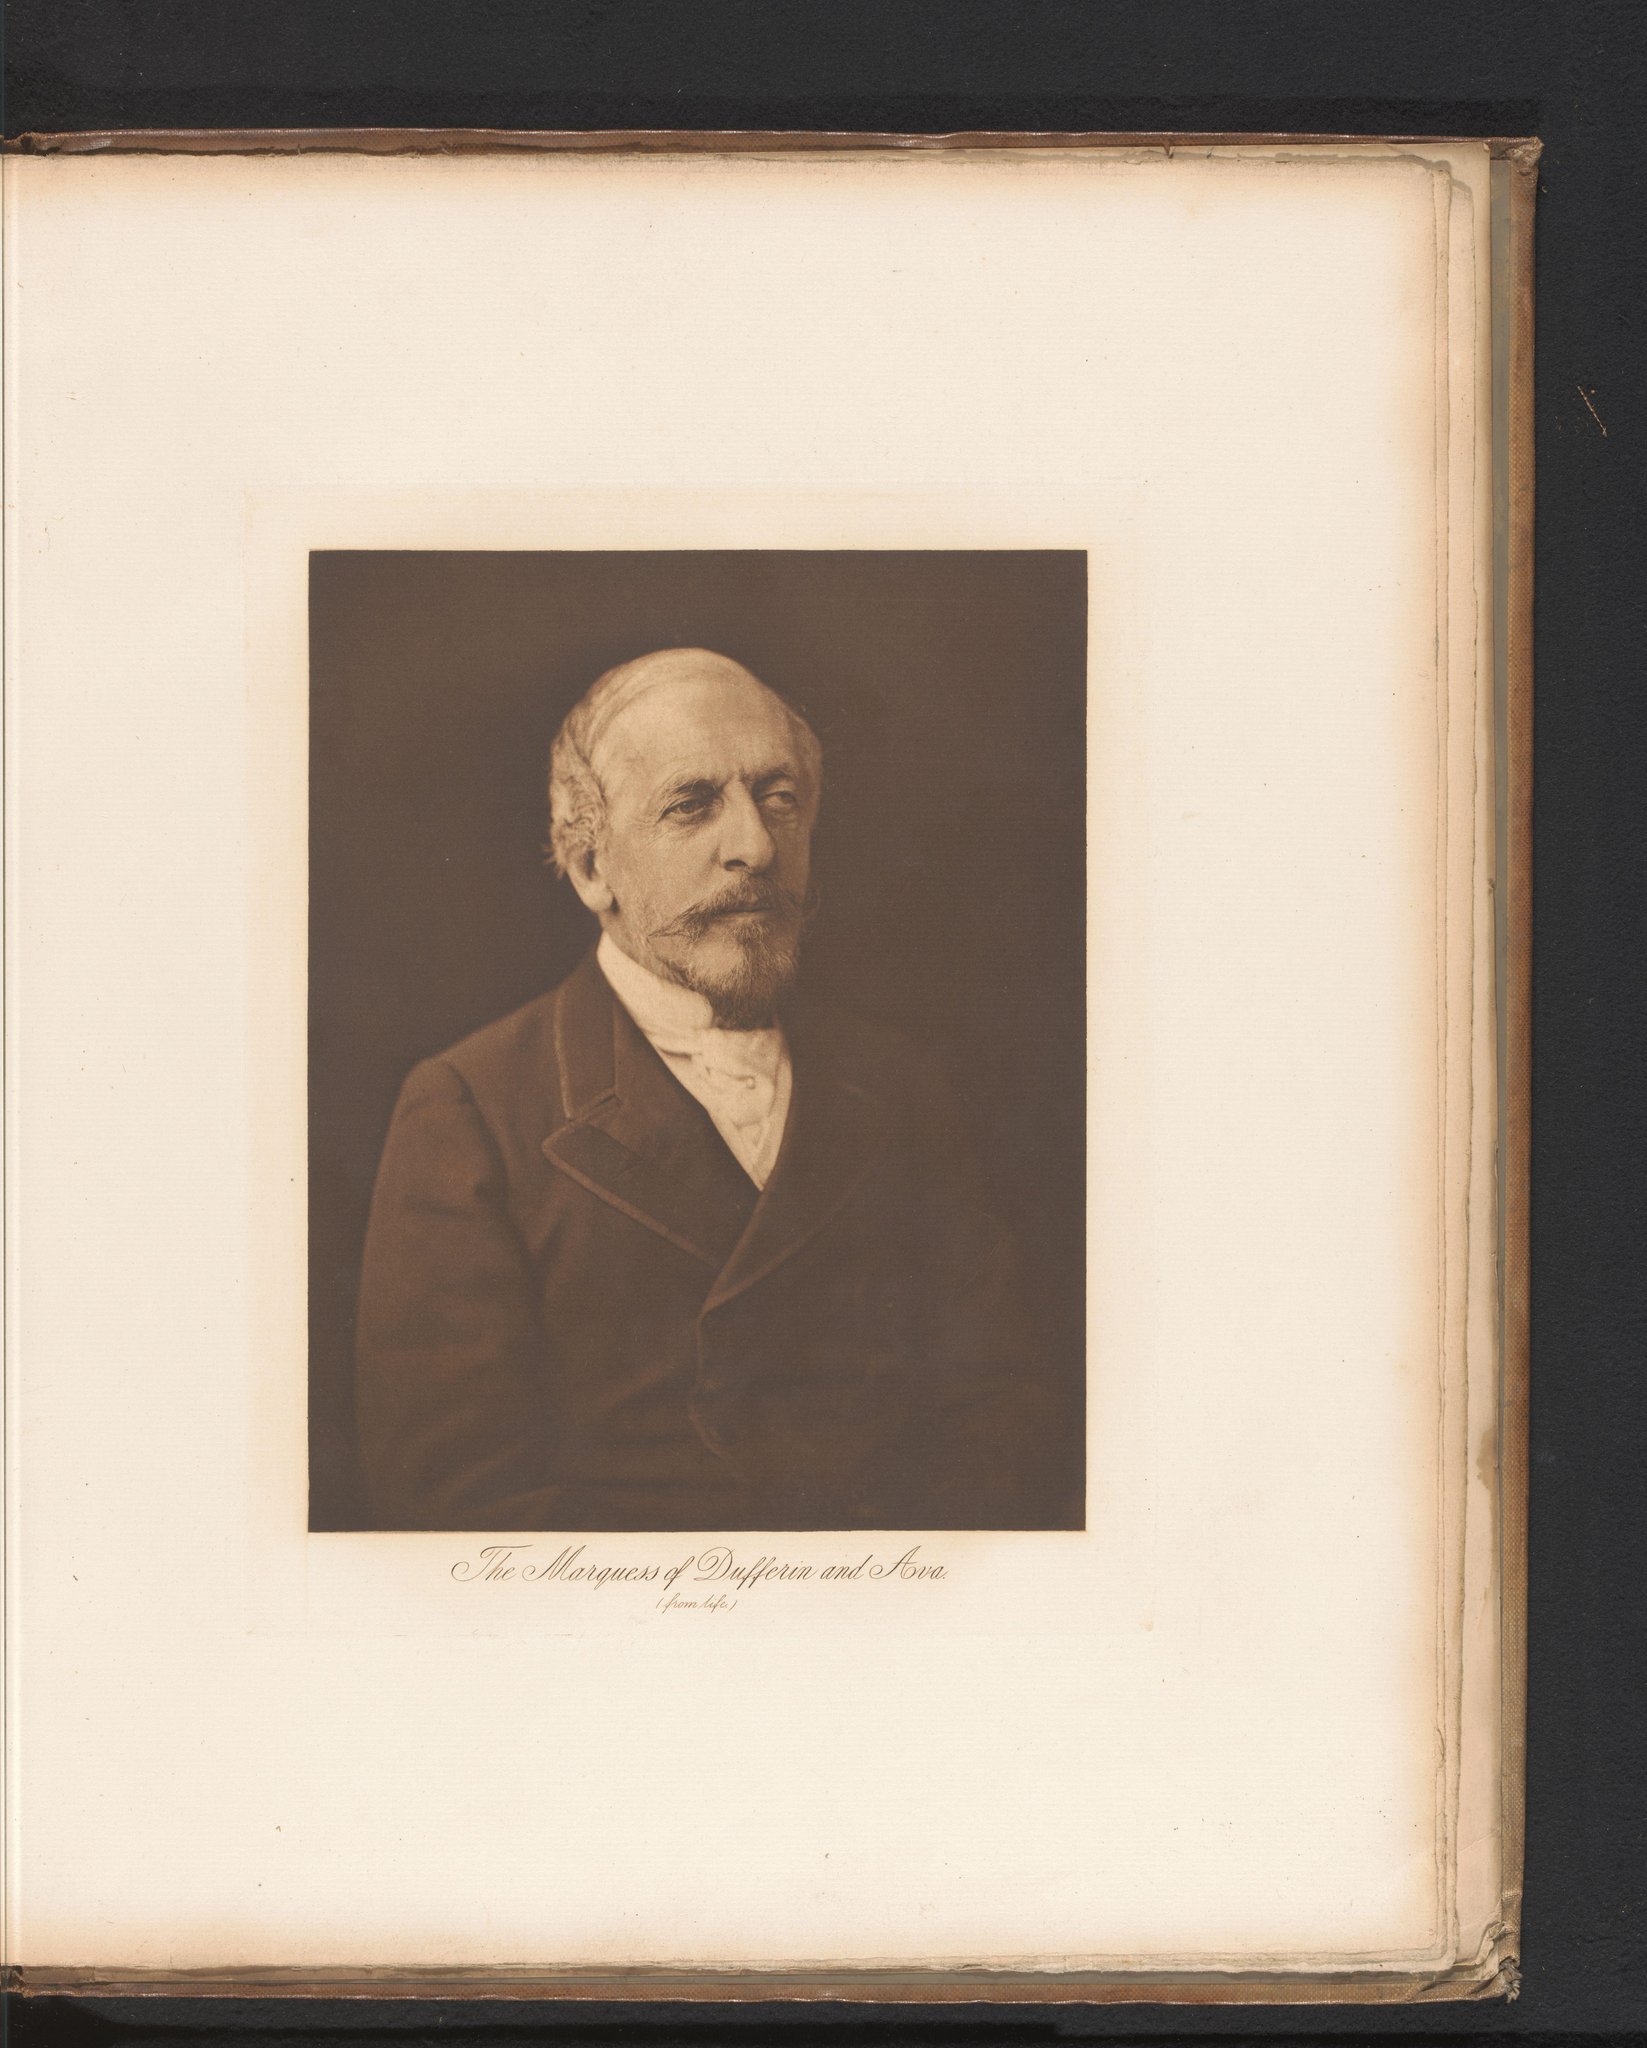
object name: page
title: The Marquess of Dufferin and Ava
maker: henry herschel hay cameron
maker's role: fotograaf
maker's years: 1852-1911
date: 1888-1893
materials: paper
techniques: photoaquatint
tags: historical persons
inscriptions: inscription: ‘The Marquess of Dufferin and Ava./ (from life.)’